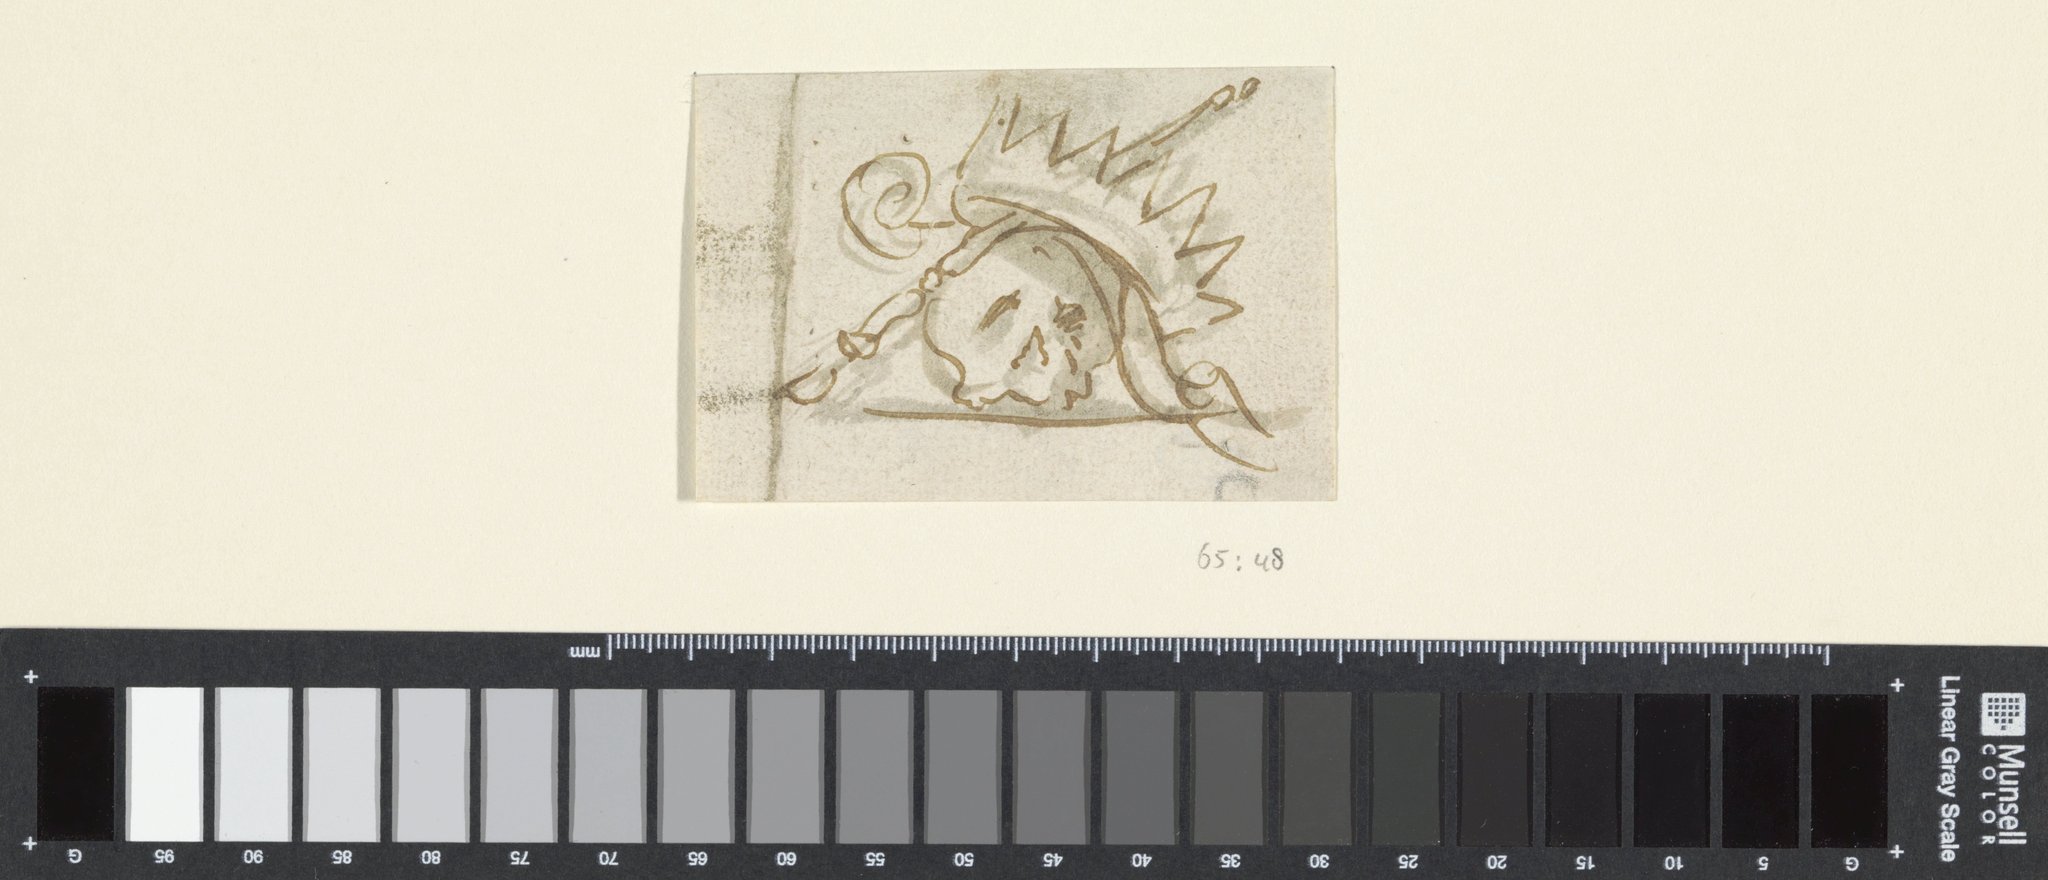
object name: ornamenttekening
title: Doodshoofd met kroon en scepter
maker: Anonymous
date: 1600-1800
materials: ink, paper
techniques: brush, pen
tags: insignia and symbols of sovereignty (crown, diadem, sceptre, orb, seal, standard, cloak, pectoral), death's head, skull (symbol of death)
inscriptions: collector's mark: Lugt 2228